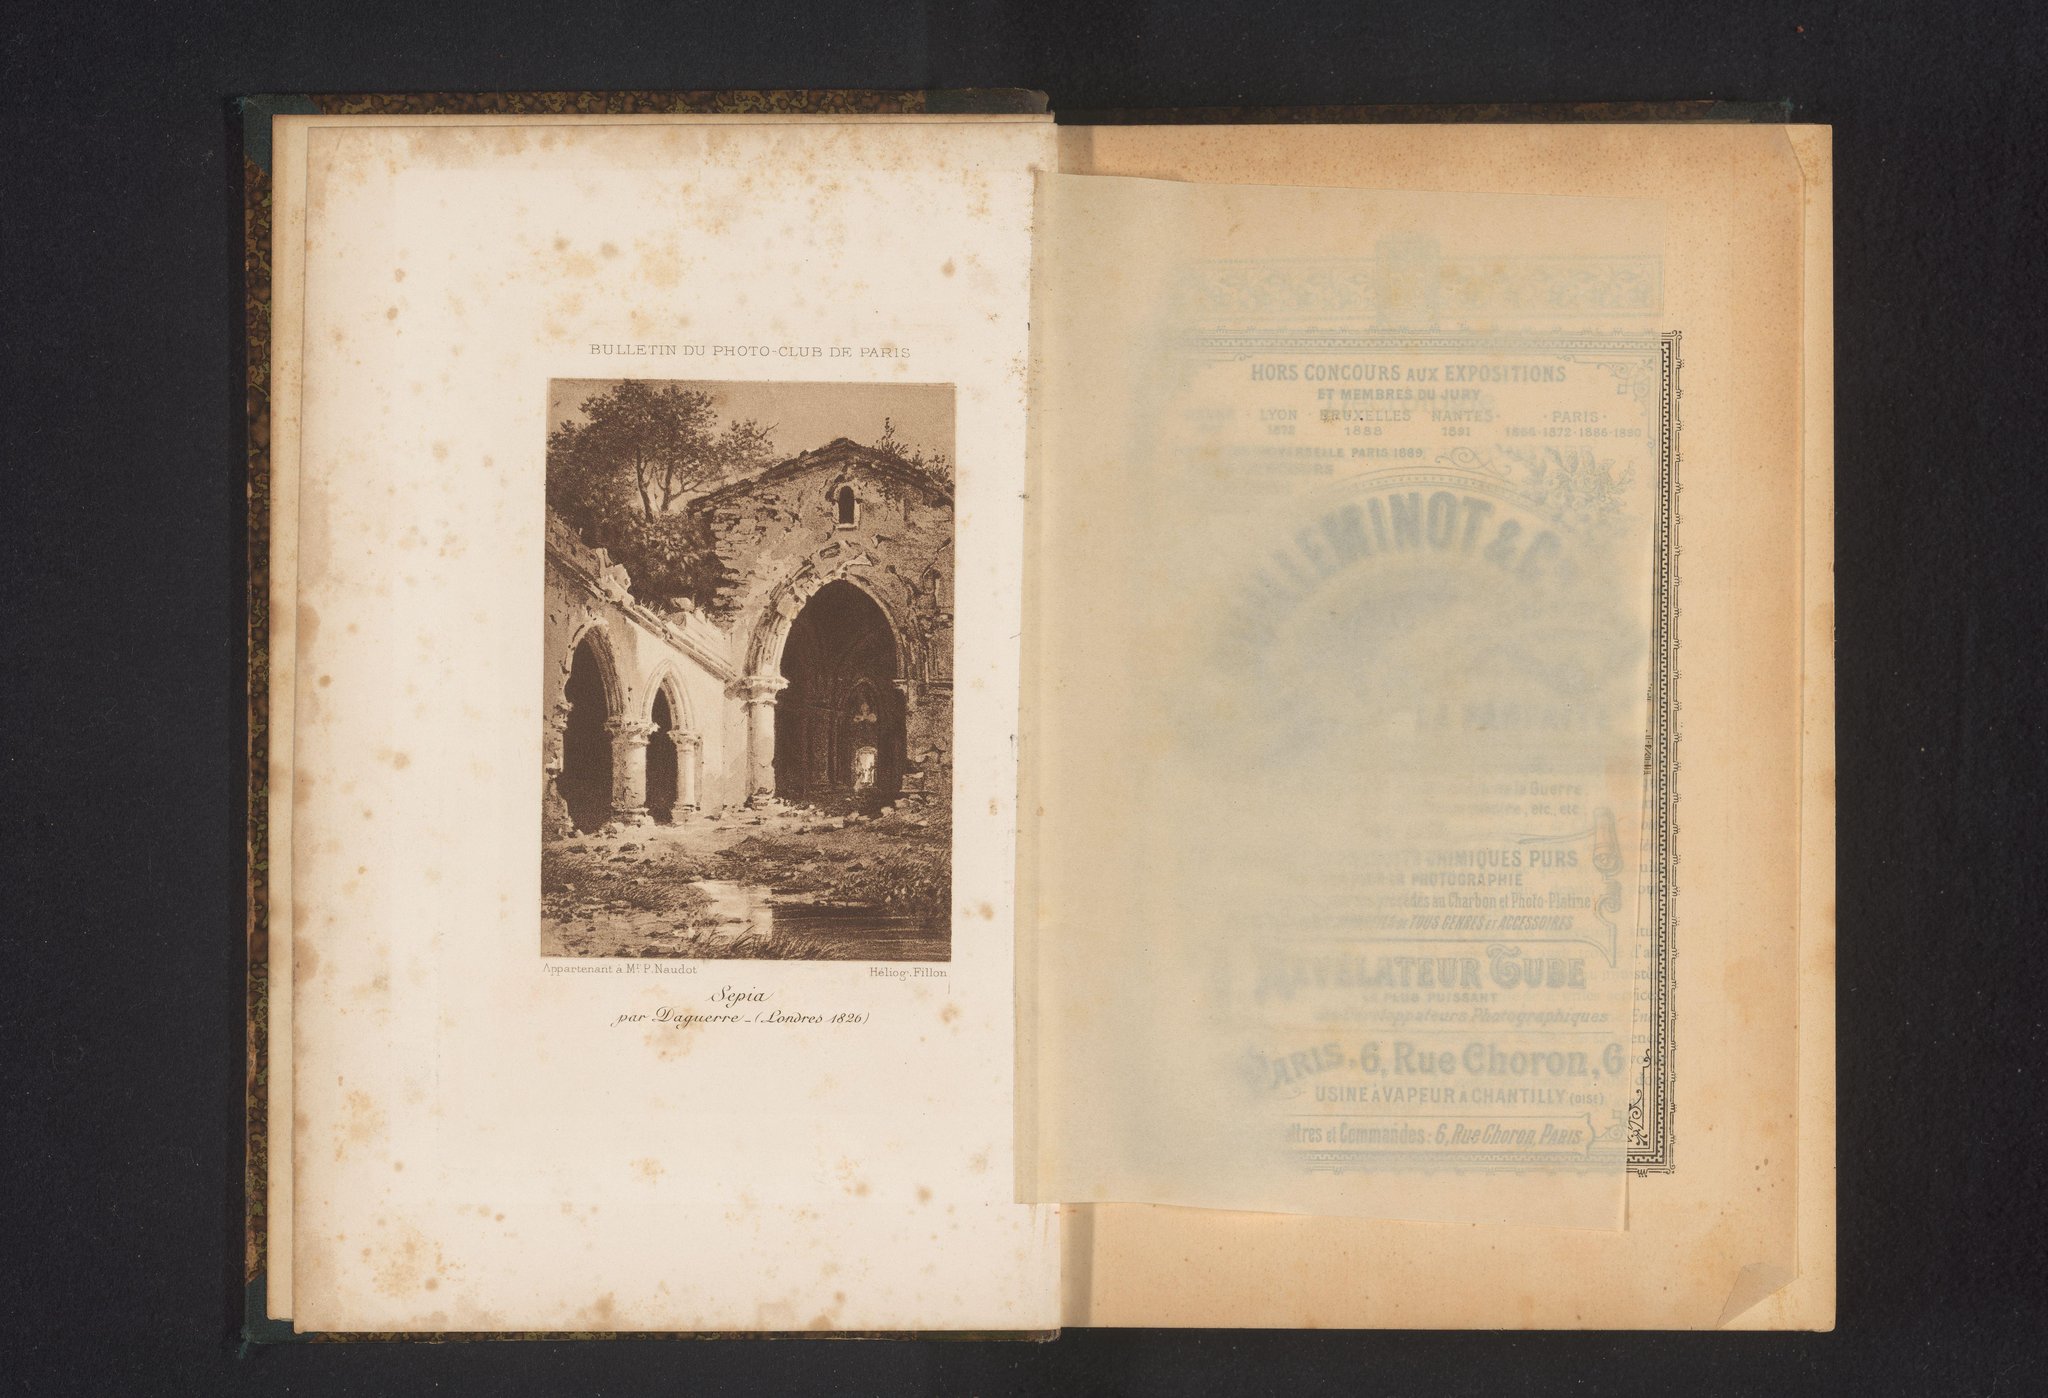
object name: page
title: Sepia par Daguerre_ (Londres 1826)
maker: paul naudot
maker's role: fotograaf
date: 1890-1895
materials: paper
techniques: photoaquatint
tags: gate, entrance, london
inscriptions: inscription: ‘Bulletin du Photo-Club de Paris’